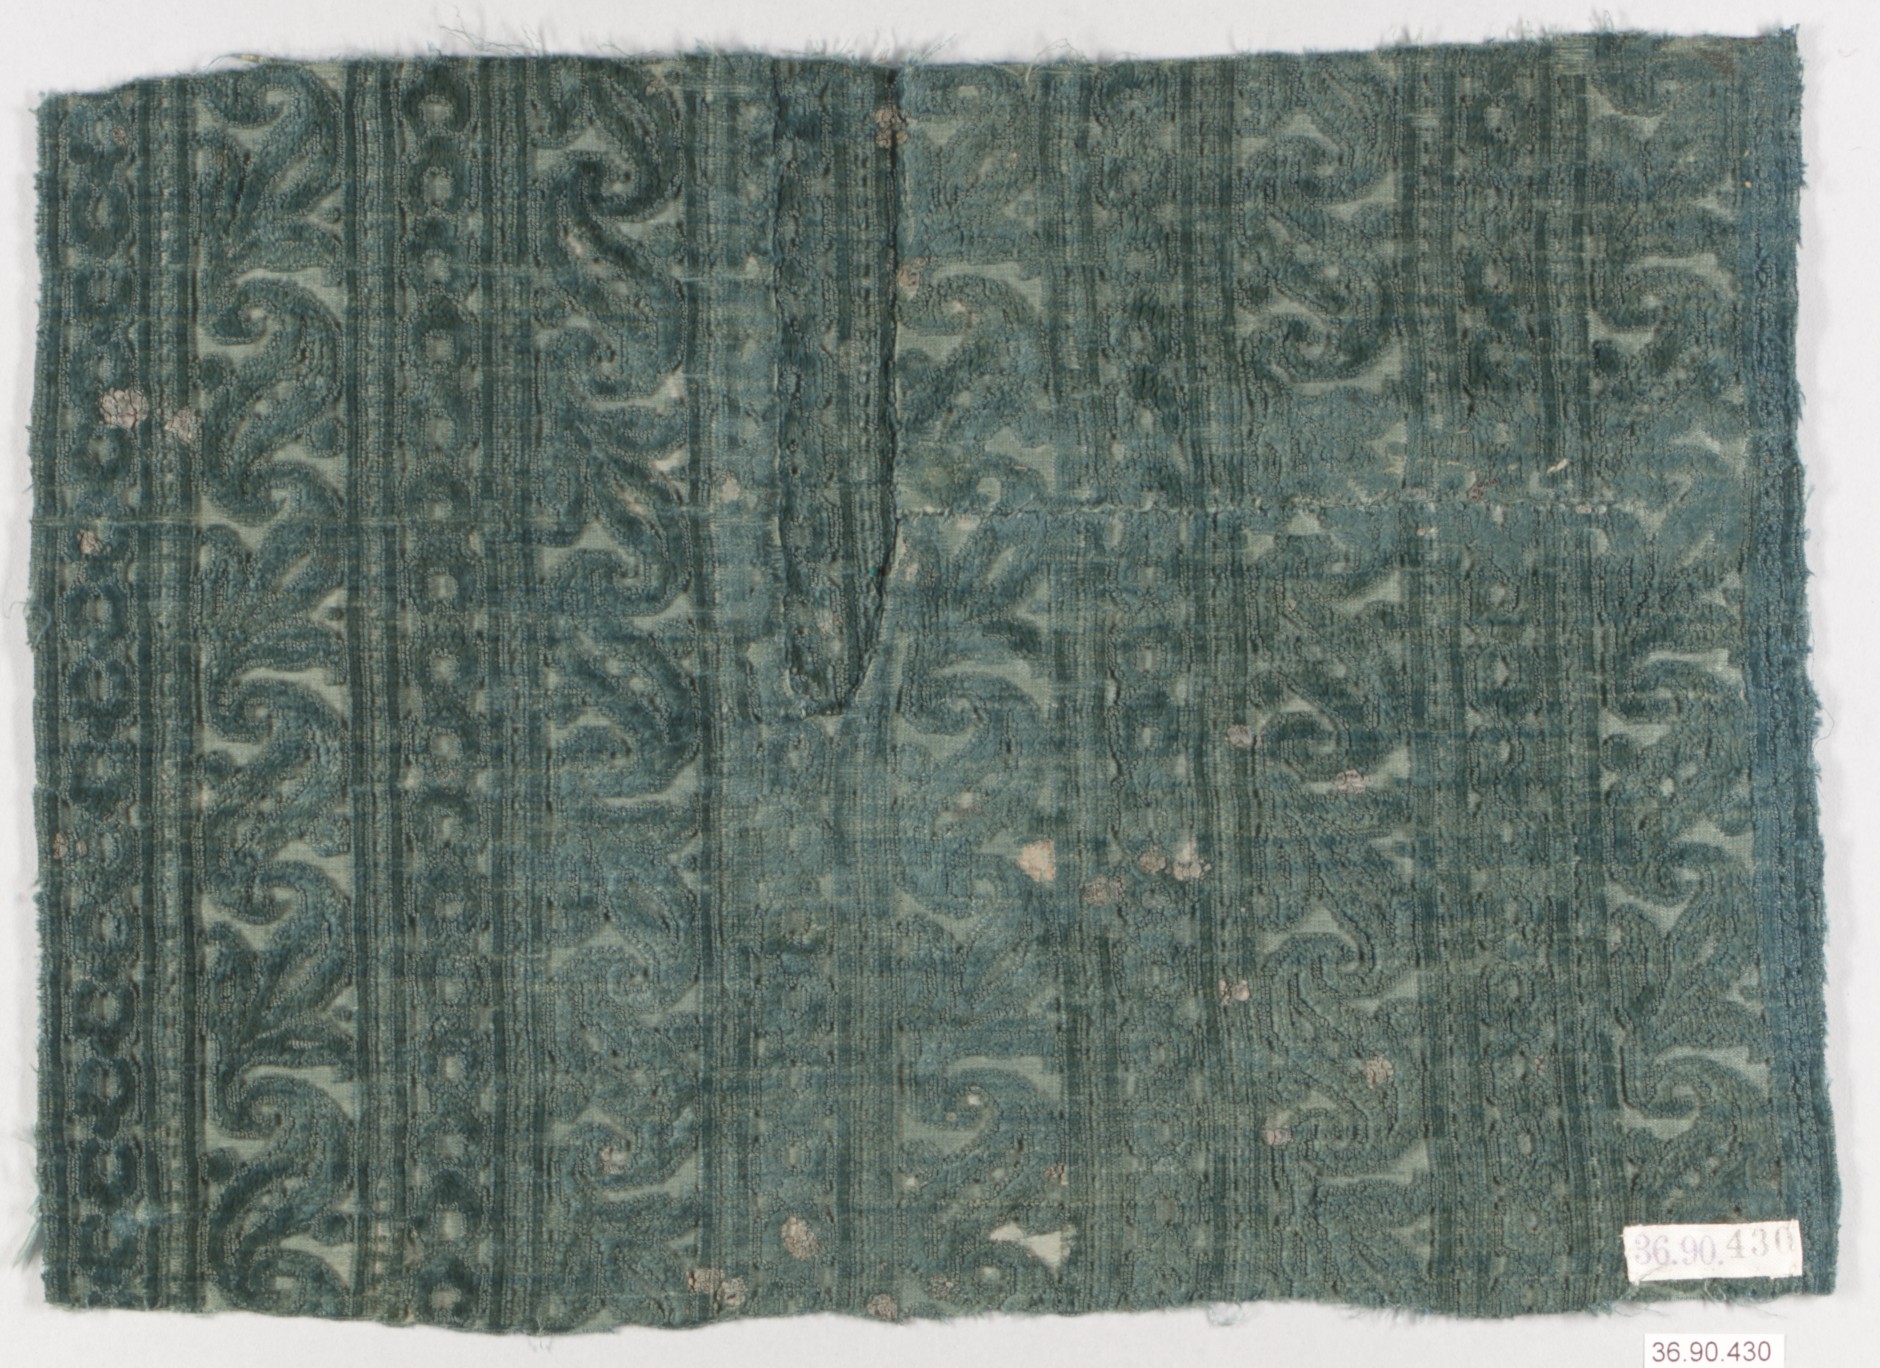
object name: piece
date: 1501-1700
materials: silk